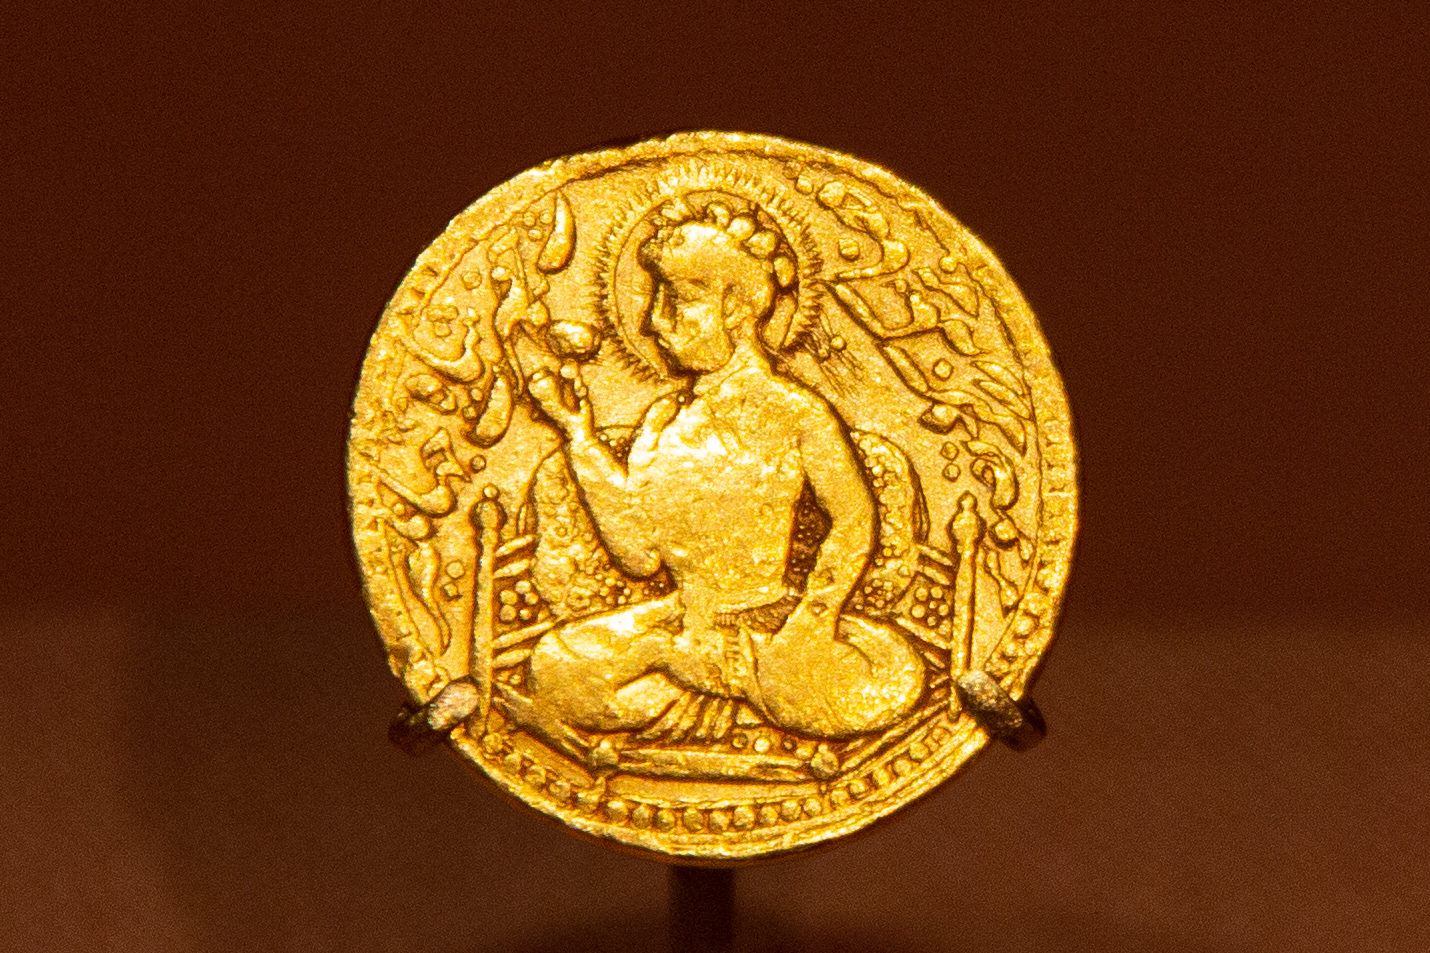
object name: coin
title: Portrait Coin of the Emperor Jahangir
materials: gold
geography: india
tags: emperors,portraits